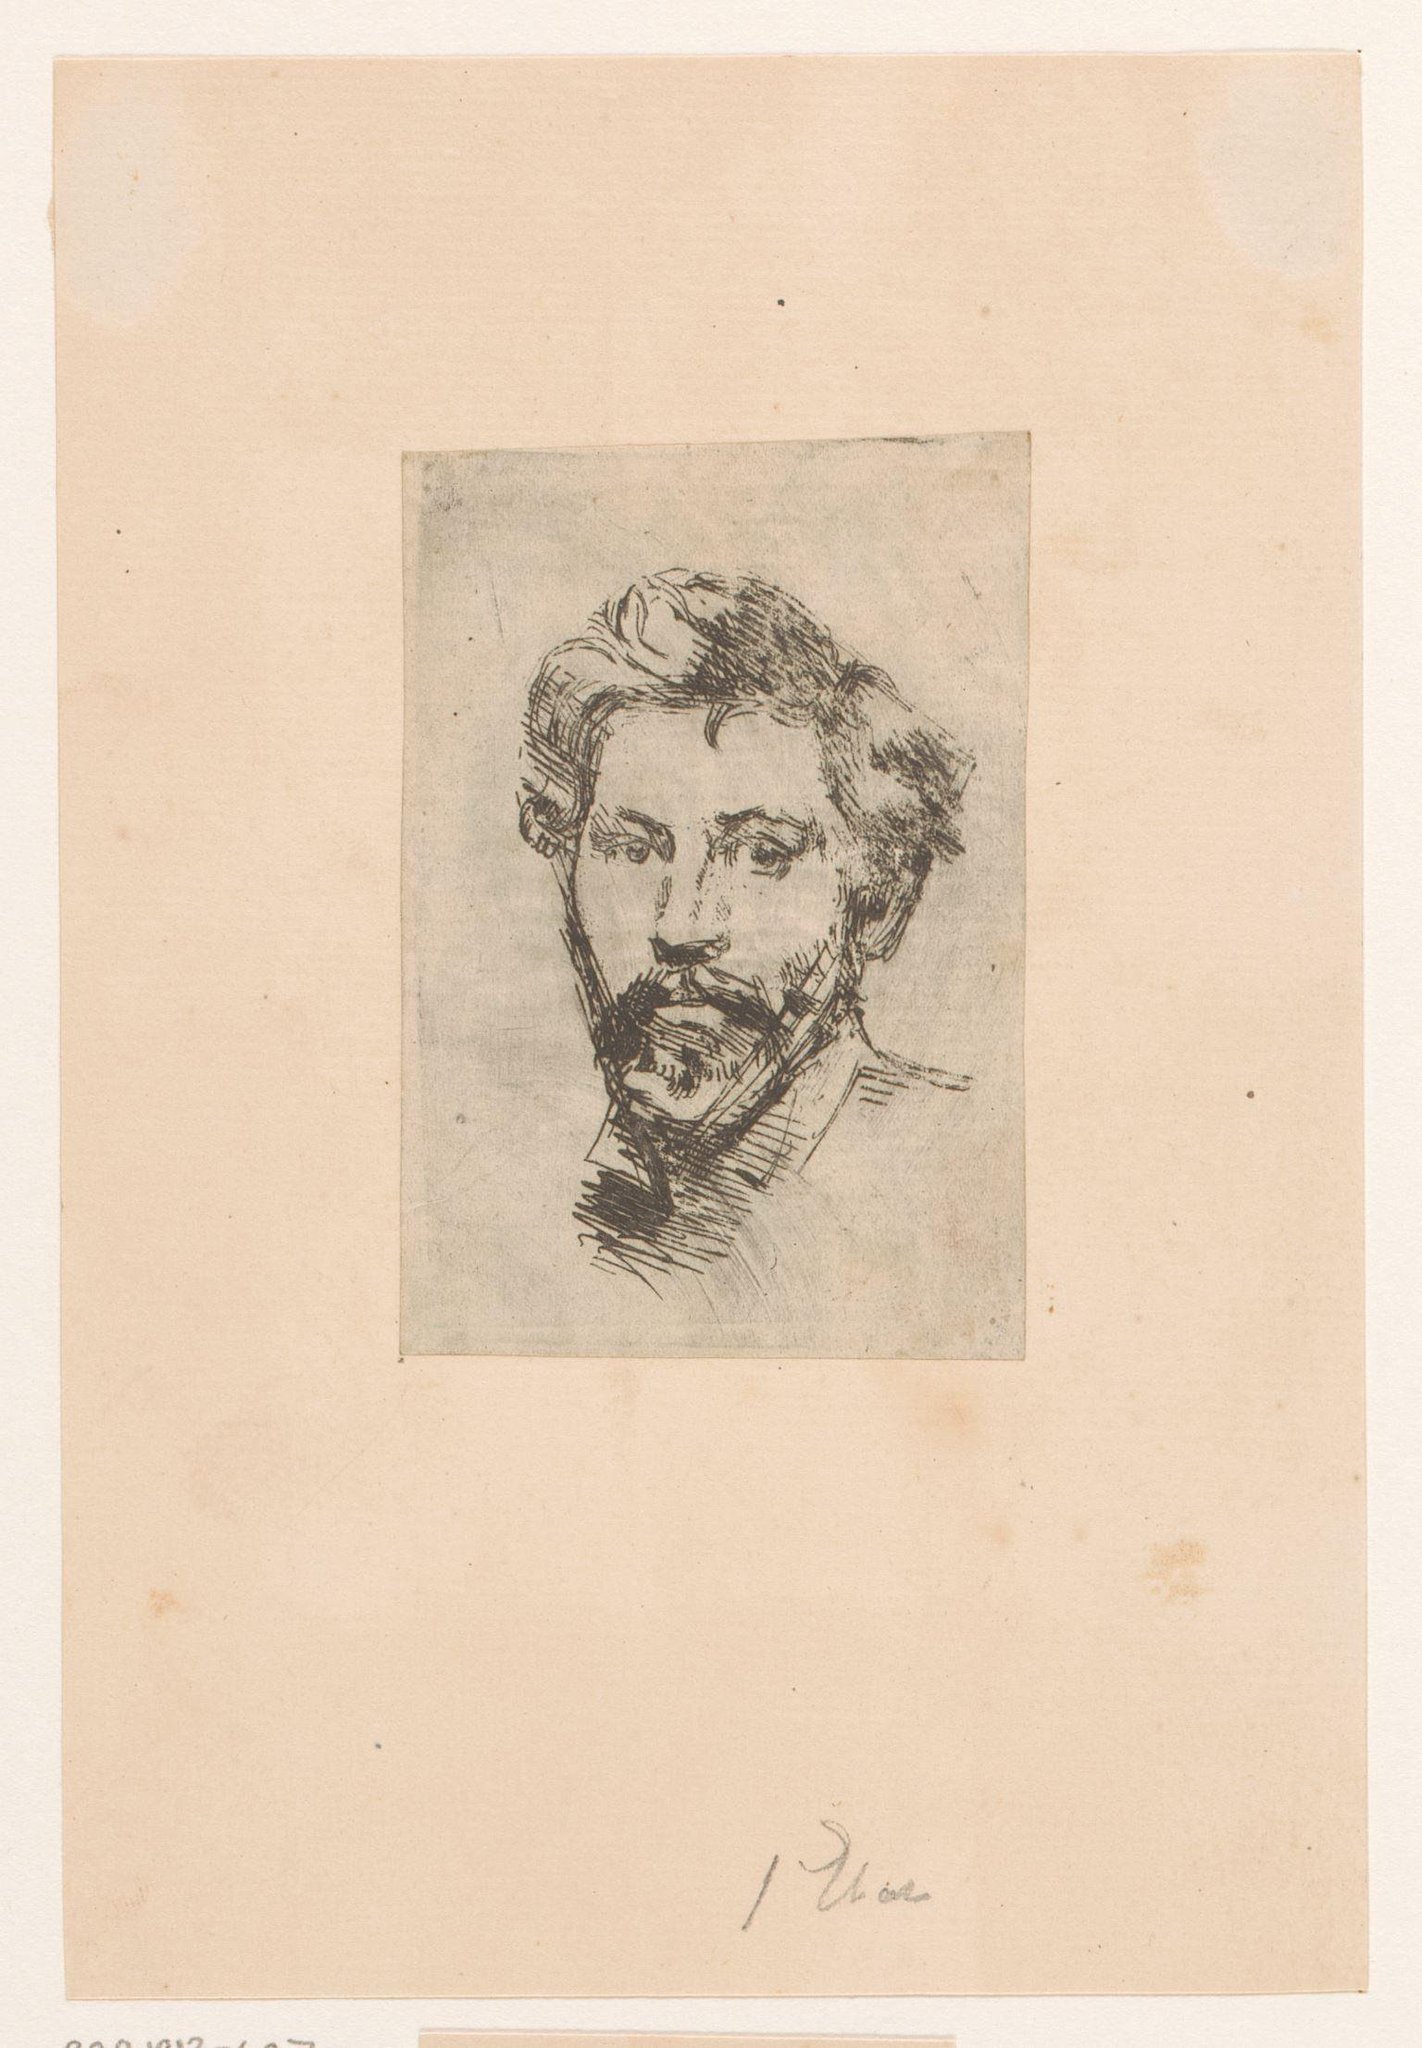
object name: print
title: Portret van een onbekende man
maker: adrien de witte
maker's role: print maker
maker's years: 1850-1935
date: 1860-1913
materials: paper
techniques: etching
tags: adult man, historical persons, beard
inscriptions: collector's mark: Lugt 2228